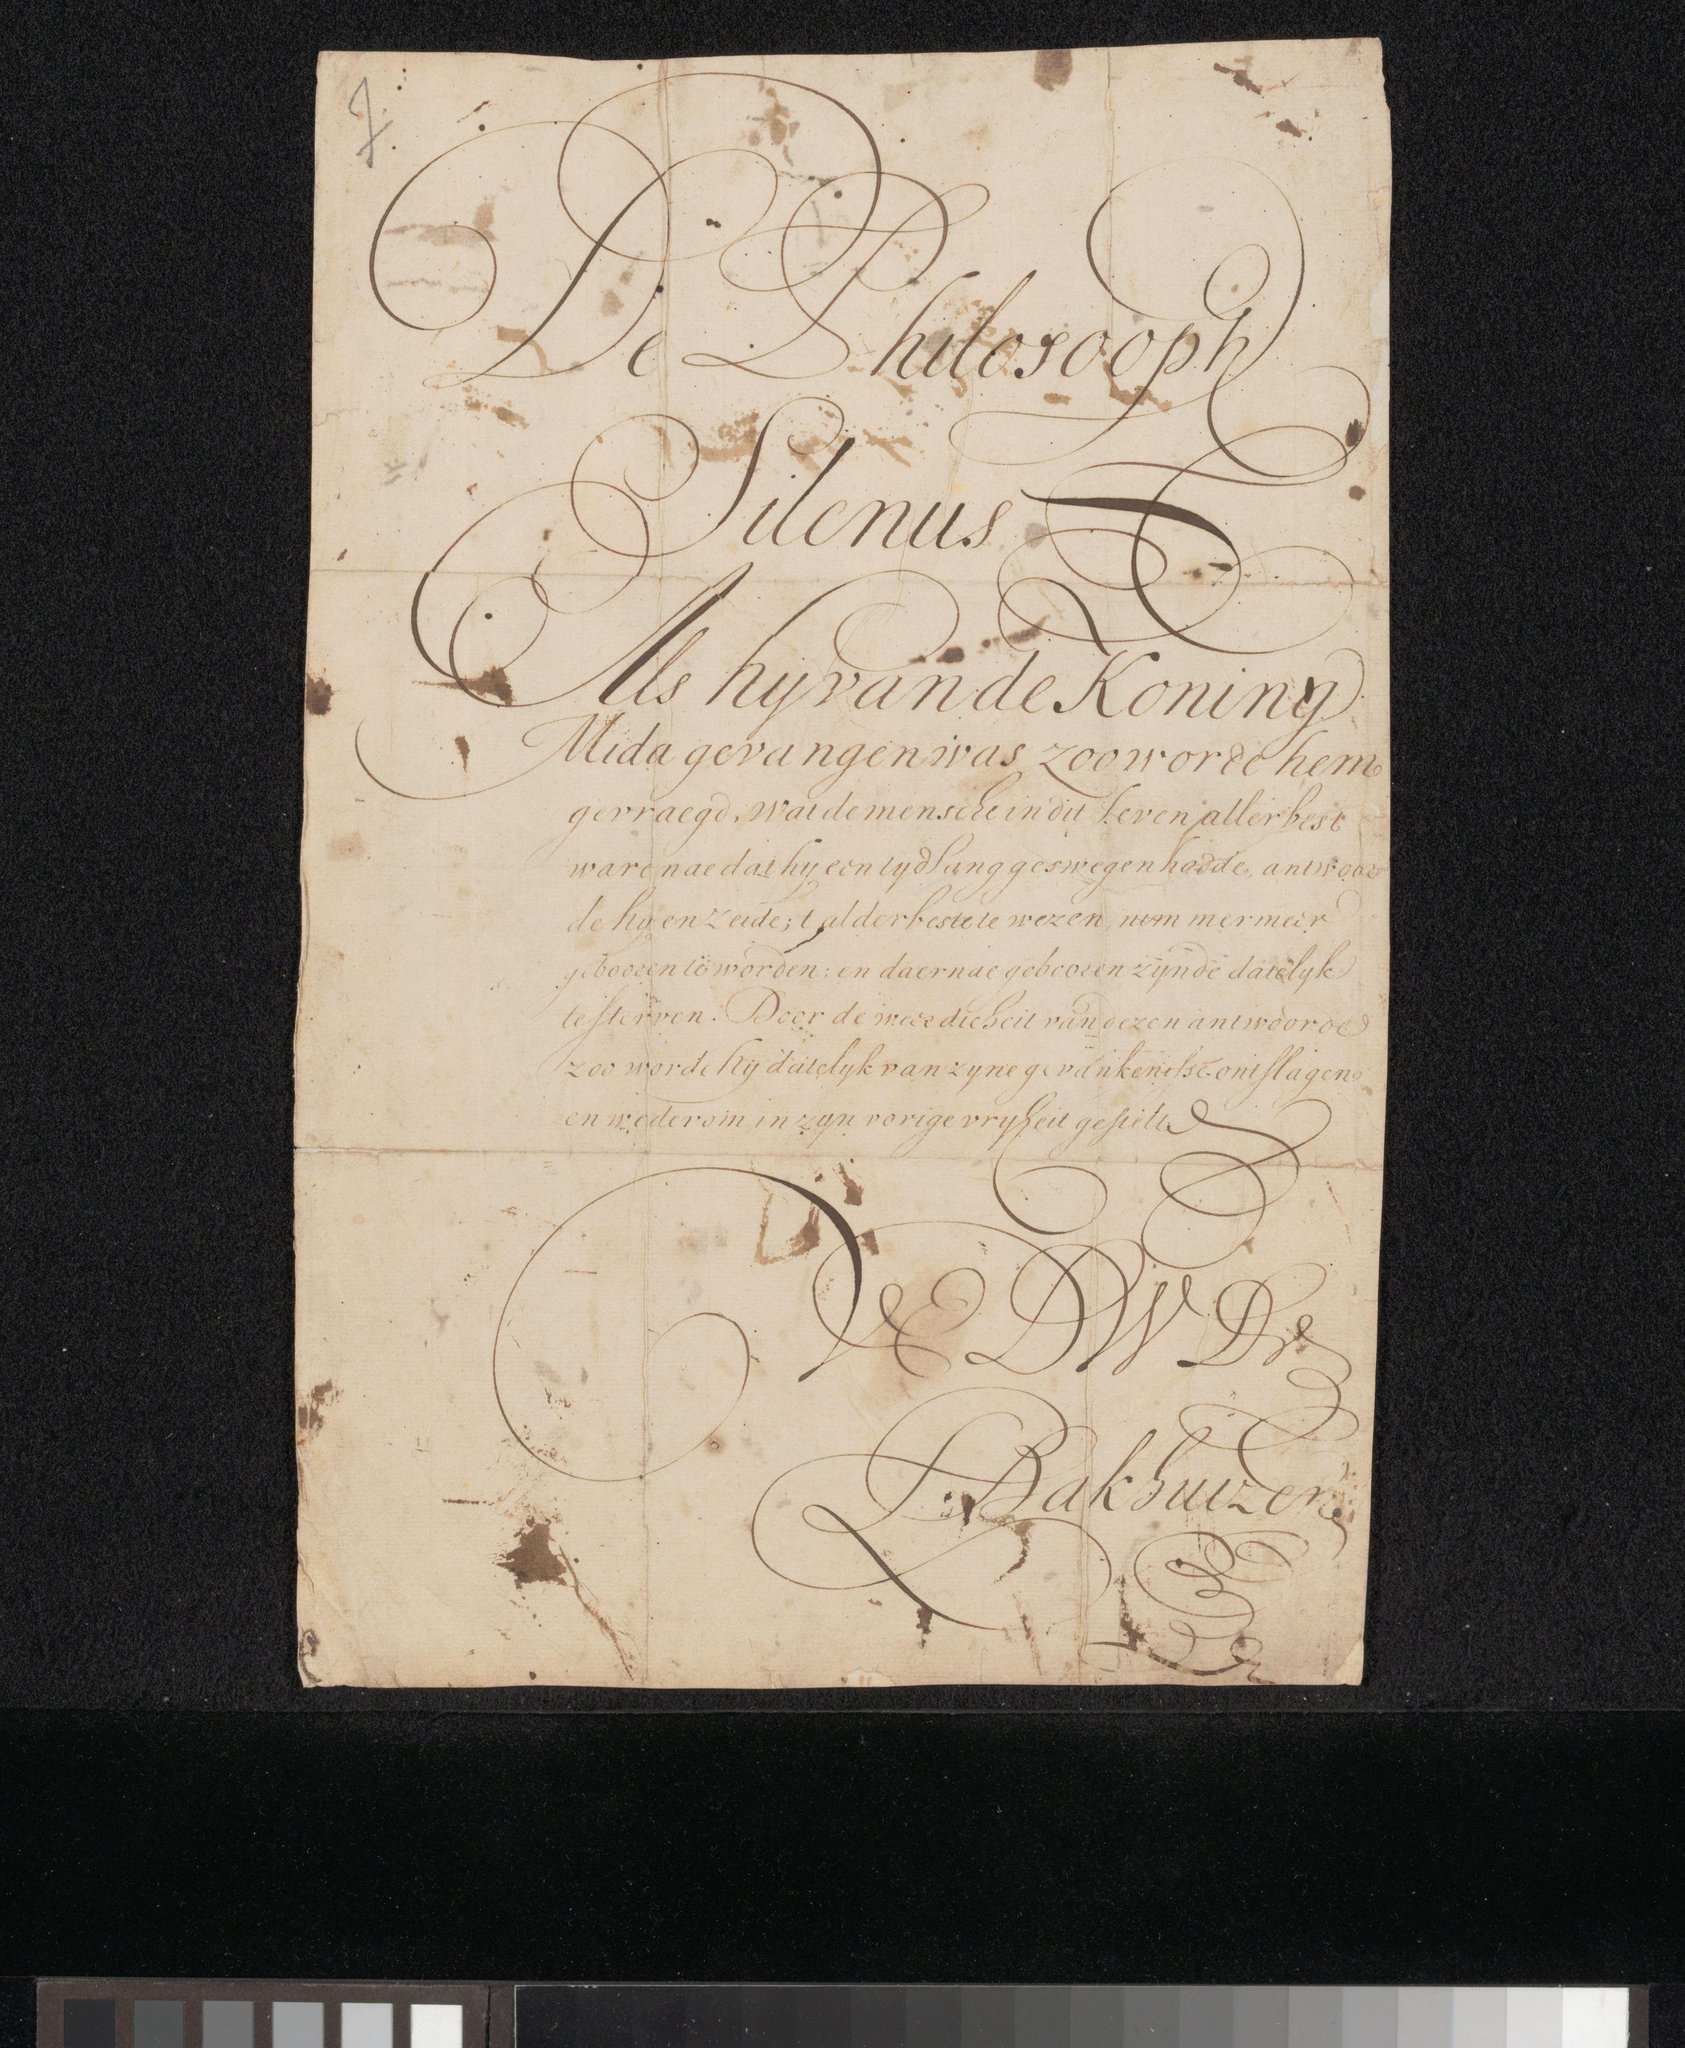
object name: manuscript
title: Proef van kalligrafie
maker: ludolf bakhuysen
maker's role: draughtsman, print maker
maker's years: 1631-1708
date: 1641-1708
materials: ink, paper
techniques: pen, writing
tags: (story of) silenus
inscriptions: collector's mark: Lugt 2233, watermark